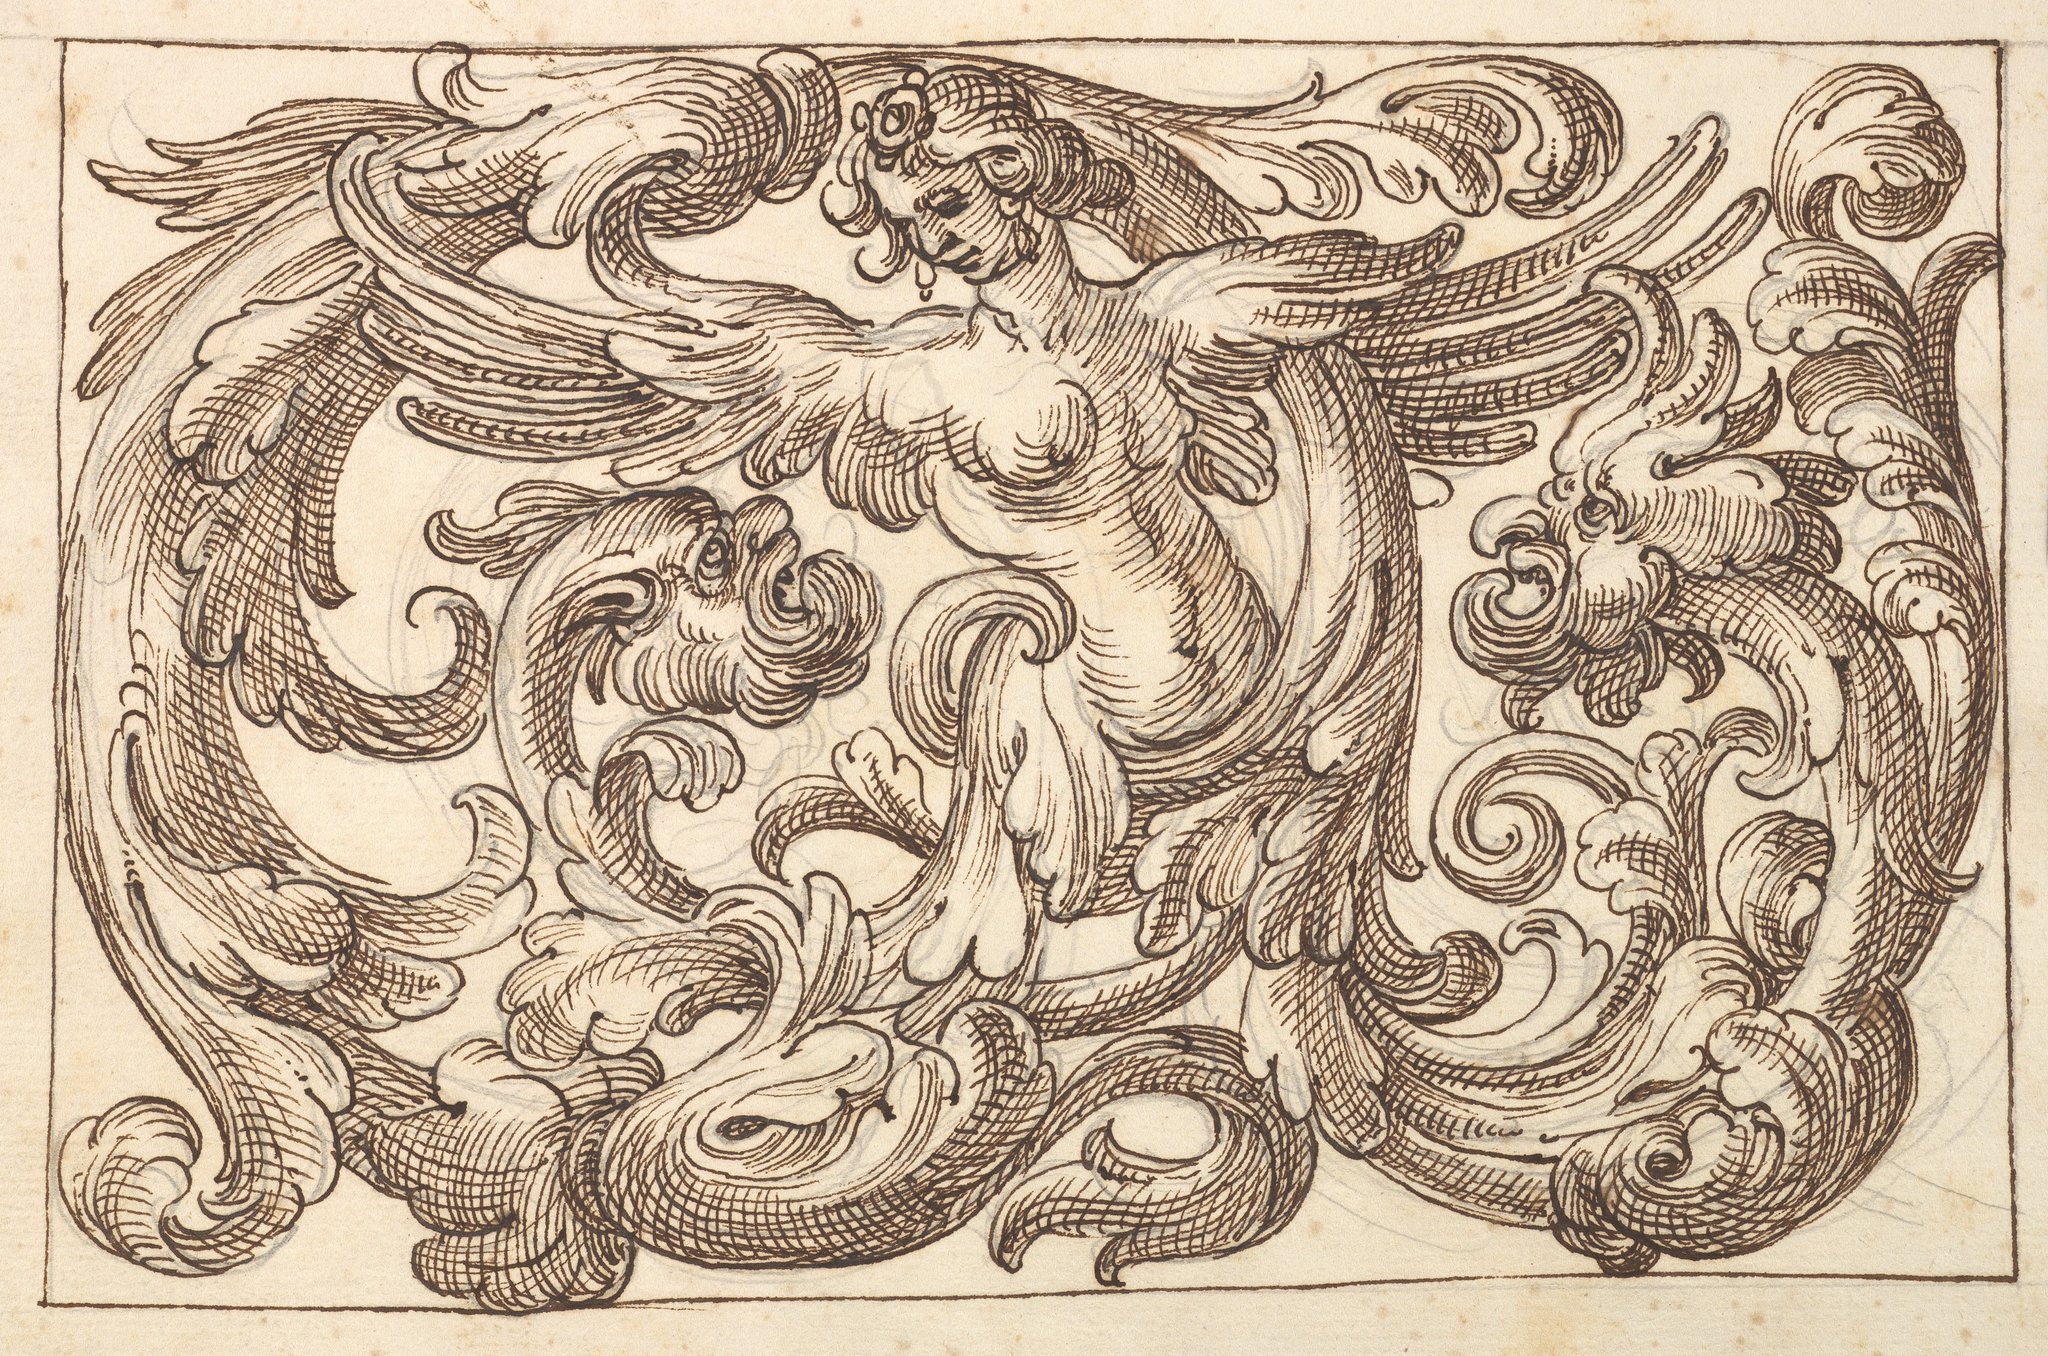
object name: collection ornament architecture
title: Horizontal Panel Design with a Female Figure and Two Fantastical Creatures Interspersed between Acanthus Rinceaux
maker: anonymous, italian, venetian, 17th century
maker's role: artist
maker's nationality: italian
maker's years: 1600-1700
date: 1601-1700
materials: ink, drawing material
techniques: pen